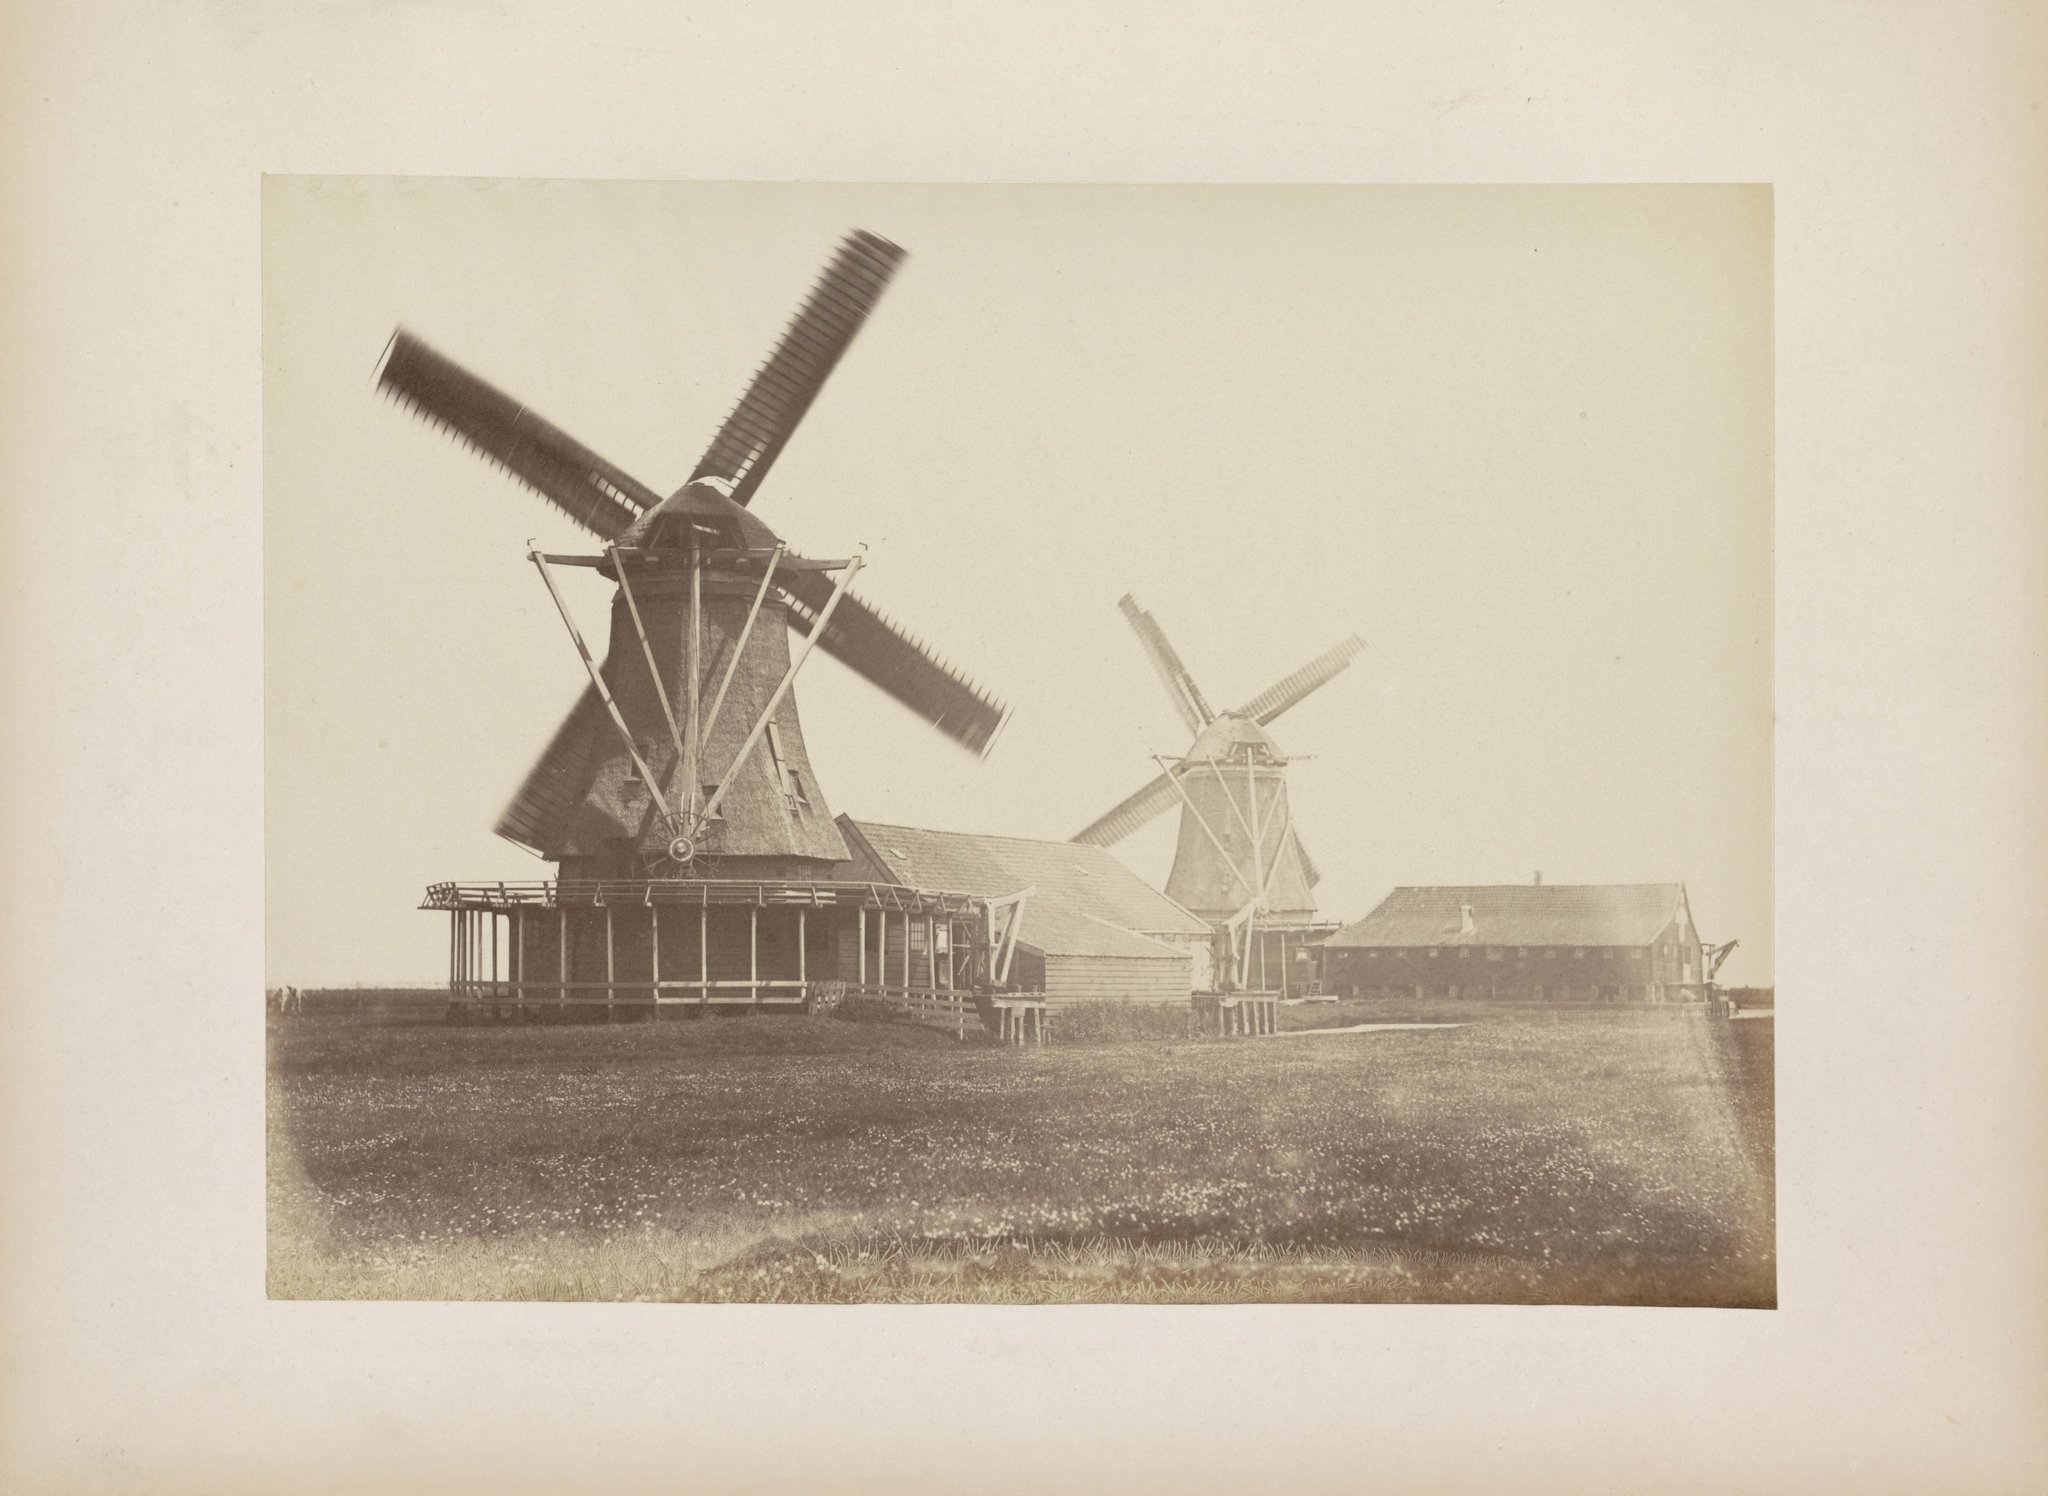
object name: photograph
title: Twee molens in Zaandam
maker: Anonymous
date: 1885-1900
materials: paper, photographic support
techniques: albumen print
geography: france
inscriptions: annotation: ‘Za[a]ndam [onder plakrand] / (Hollande)’